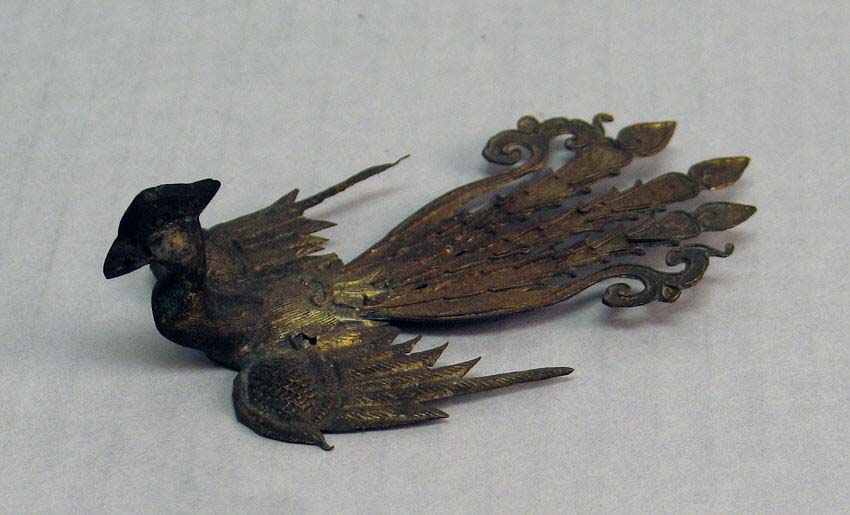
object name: ornament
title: Phoenix Ornament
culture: chinese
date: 960-1279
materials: silver gilt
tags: mythical creatures